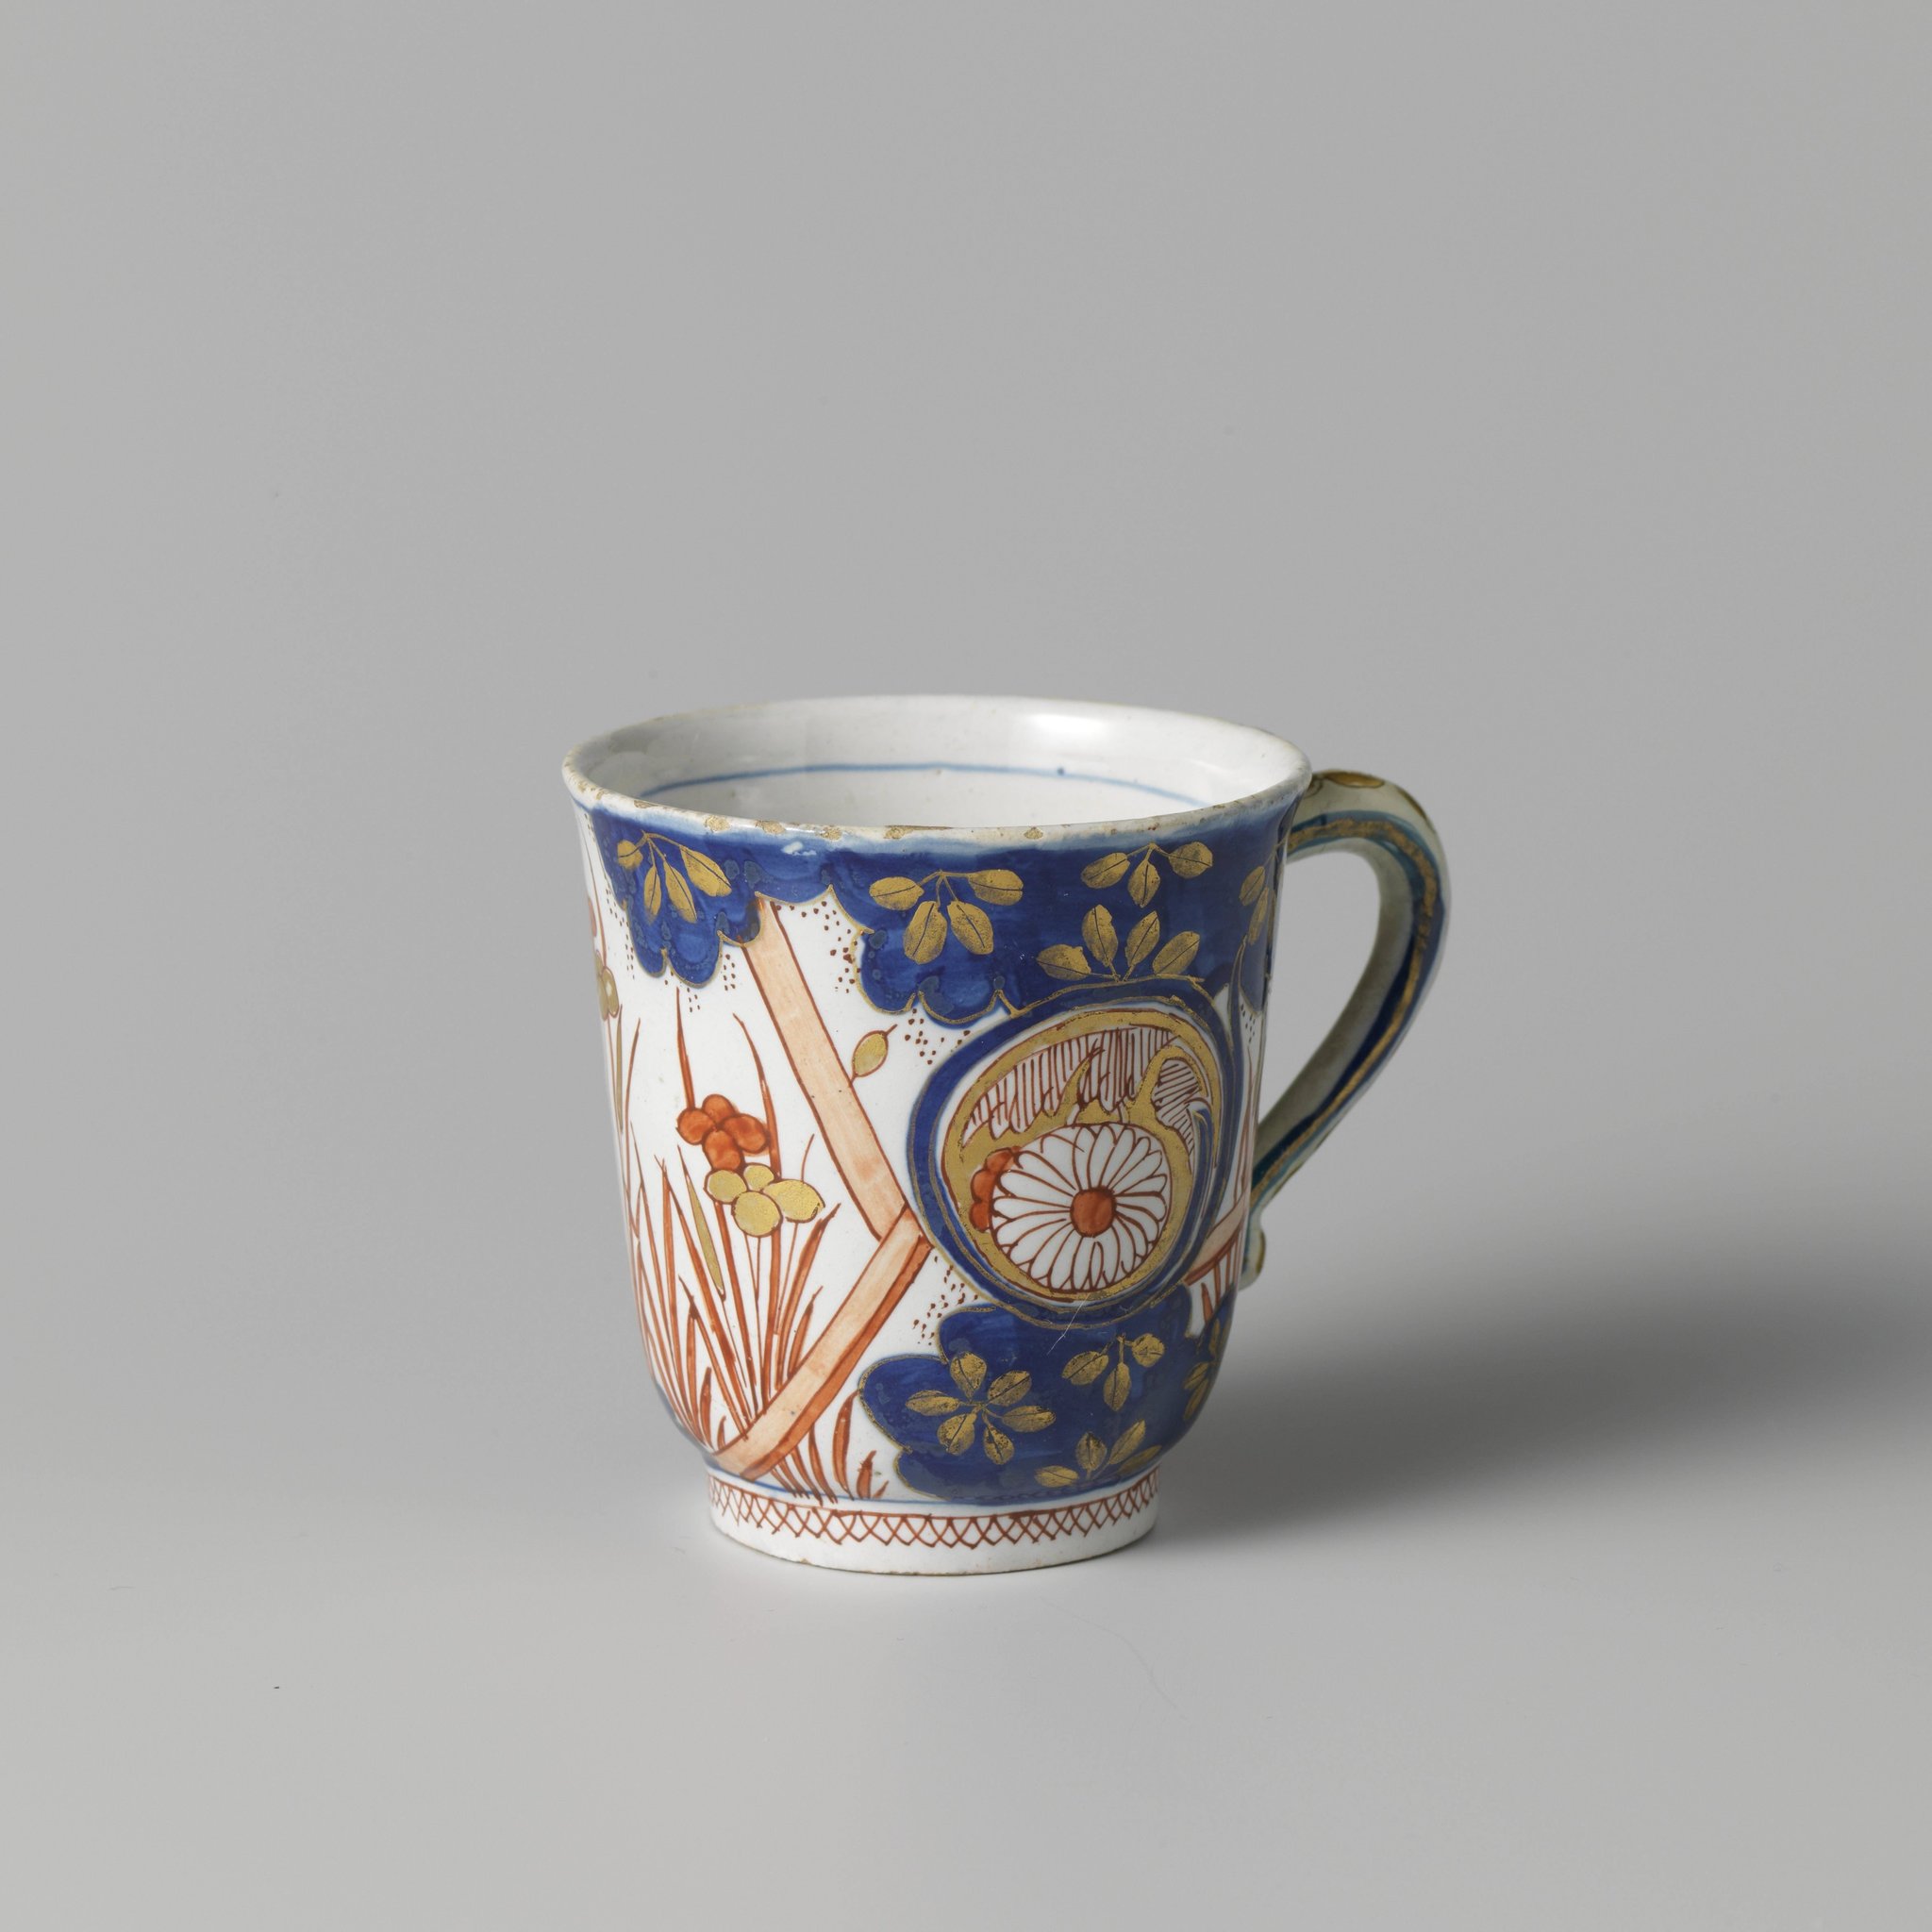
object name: cup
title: Kop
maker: pieter adriaensz. kocx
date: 1700-1725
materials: faience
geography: delft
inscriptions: mark: ‘APK (ineen)/ 78/ 87’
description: Kop van faience. Veelkleurig beschilderd met bloem- en bladdecoratie.